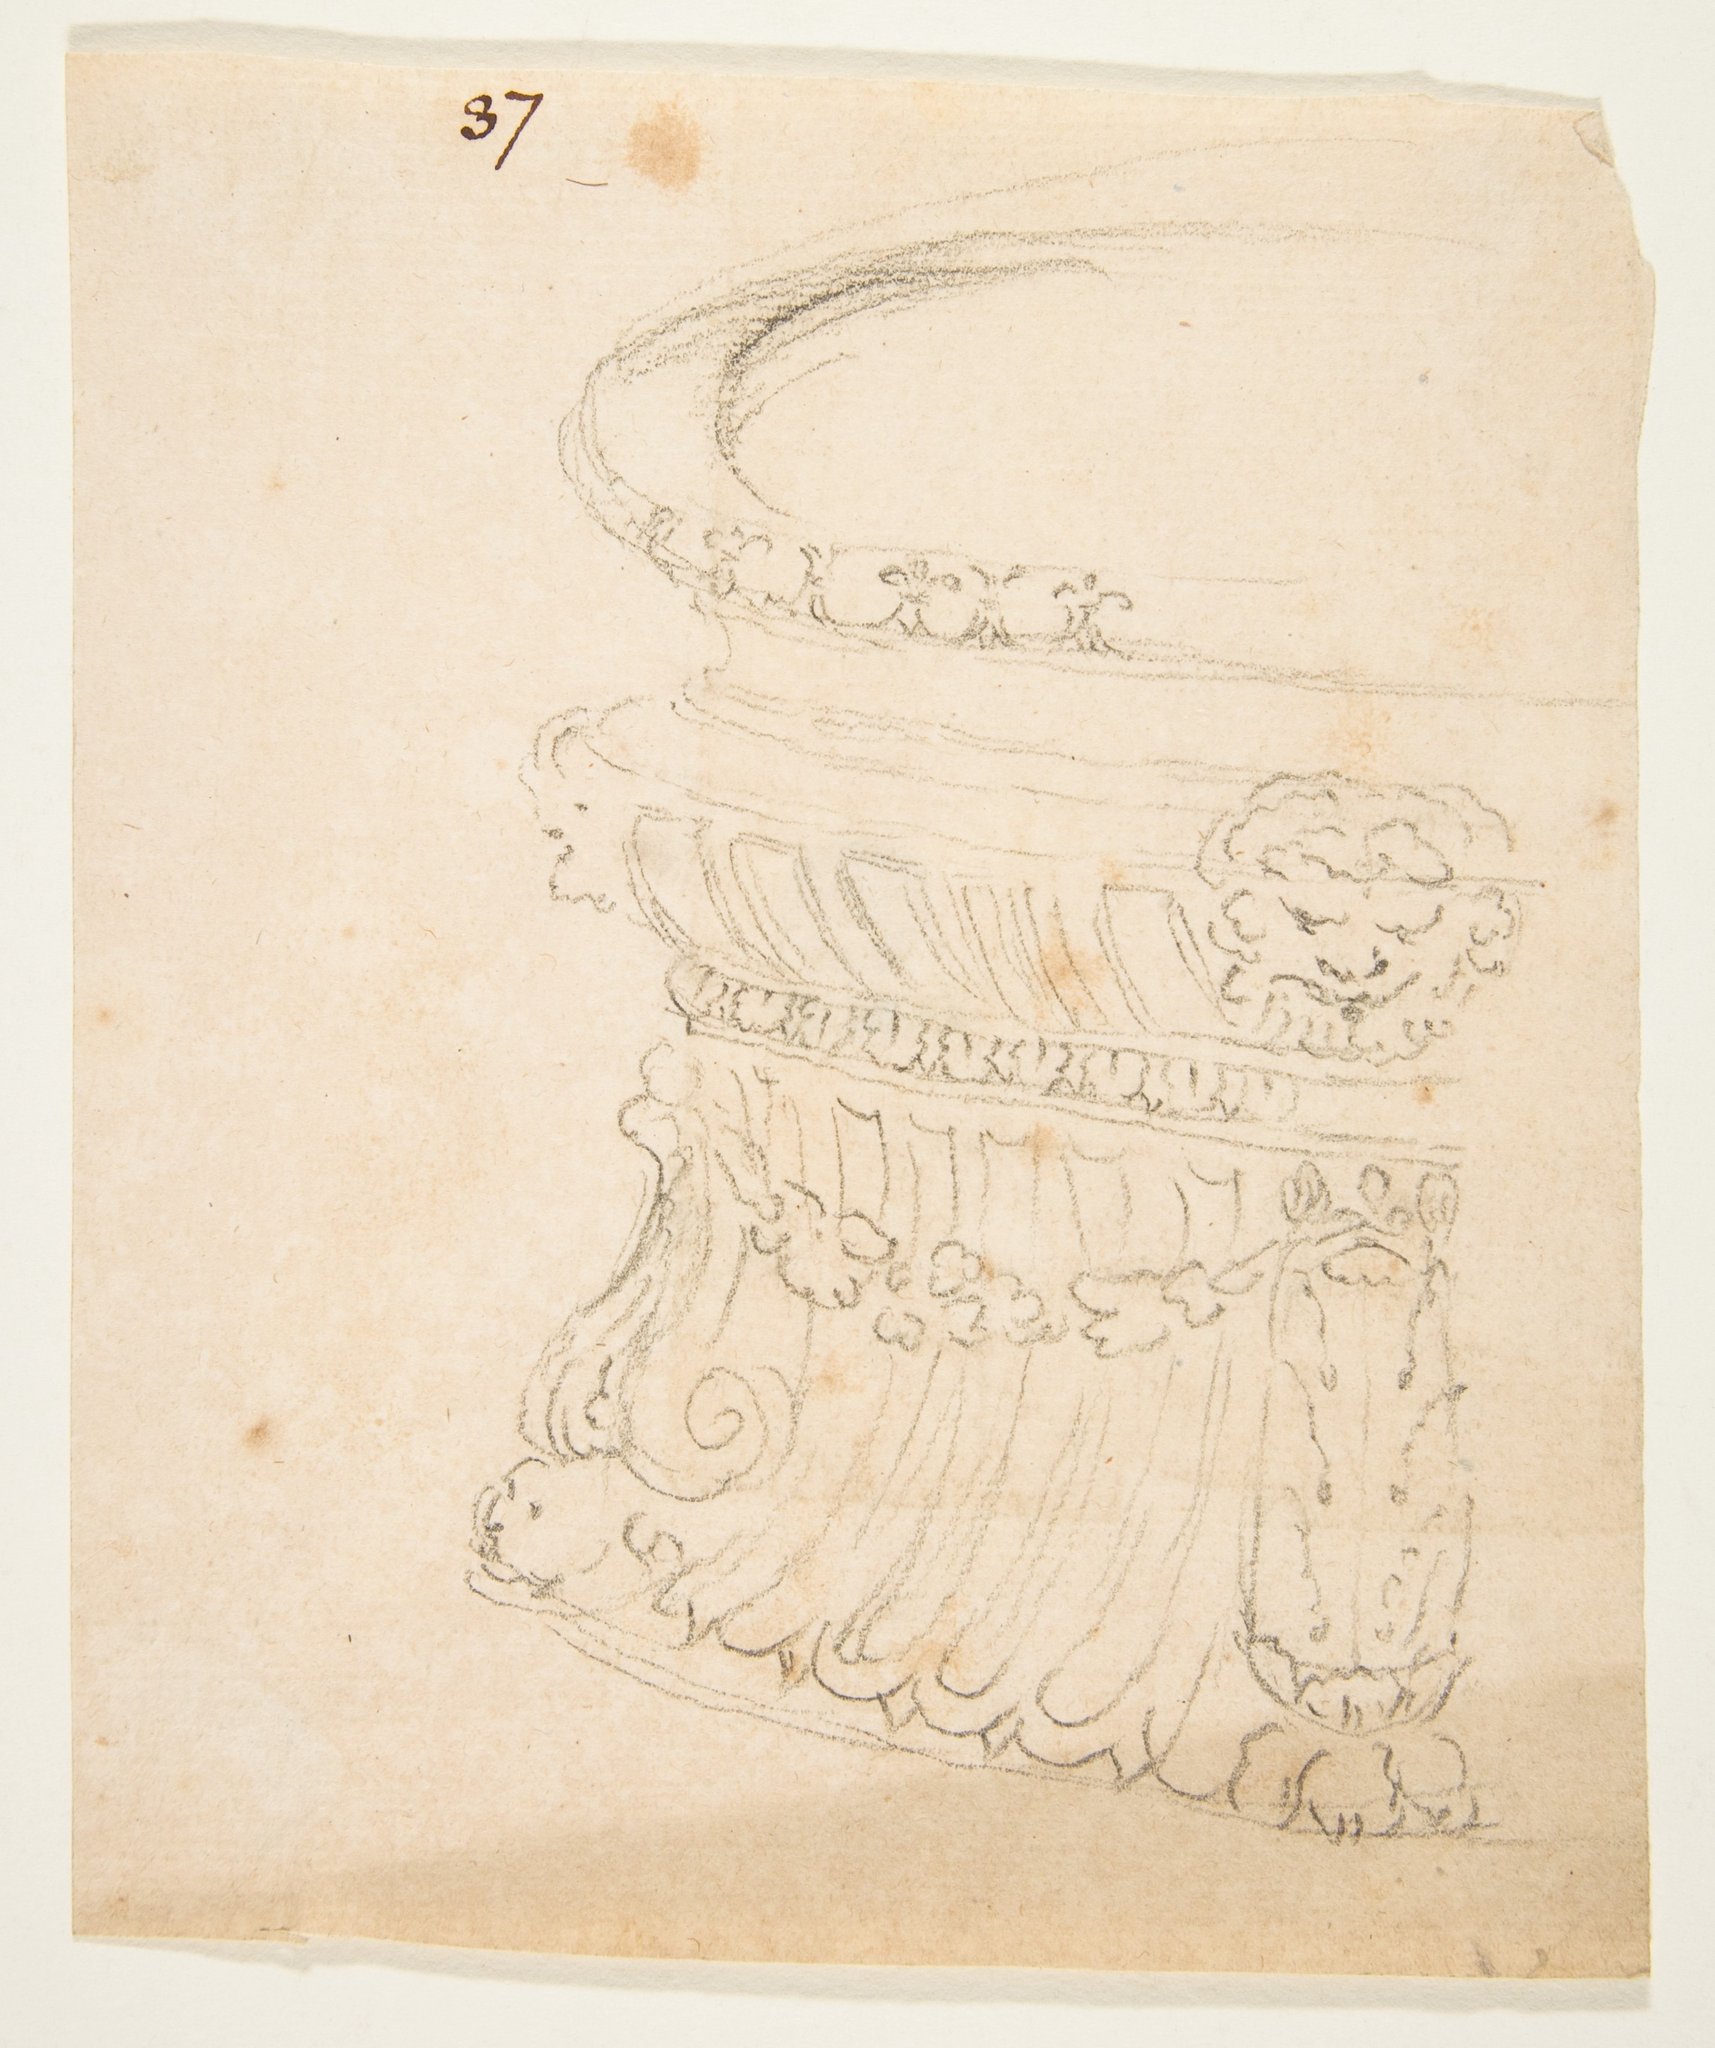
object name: drawing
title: Design for a Vessel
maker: anonymous, french, 18th century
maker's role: artist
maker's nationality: french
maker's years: 1700-1800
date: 1701-1800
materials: graphite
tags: vessels